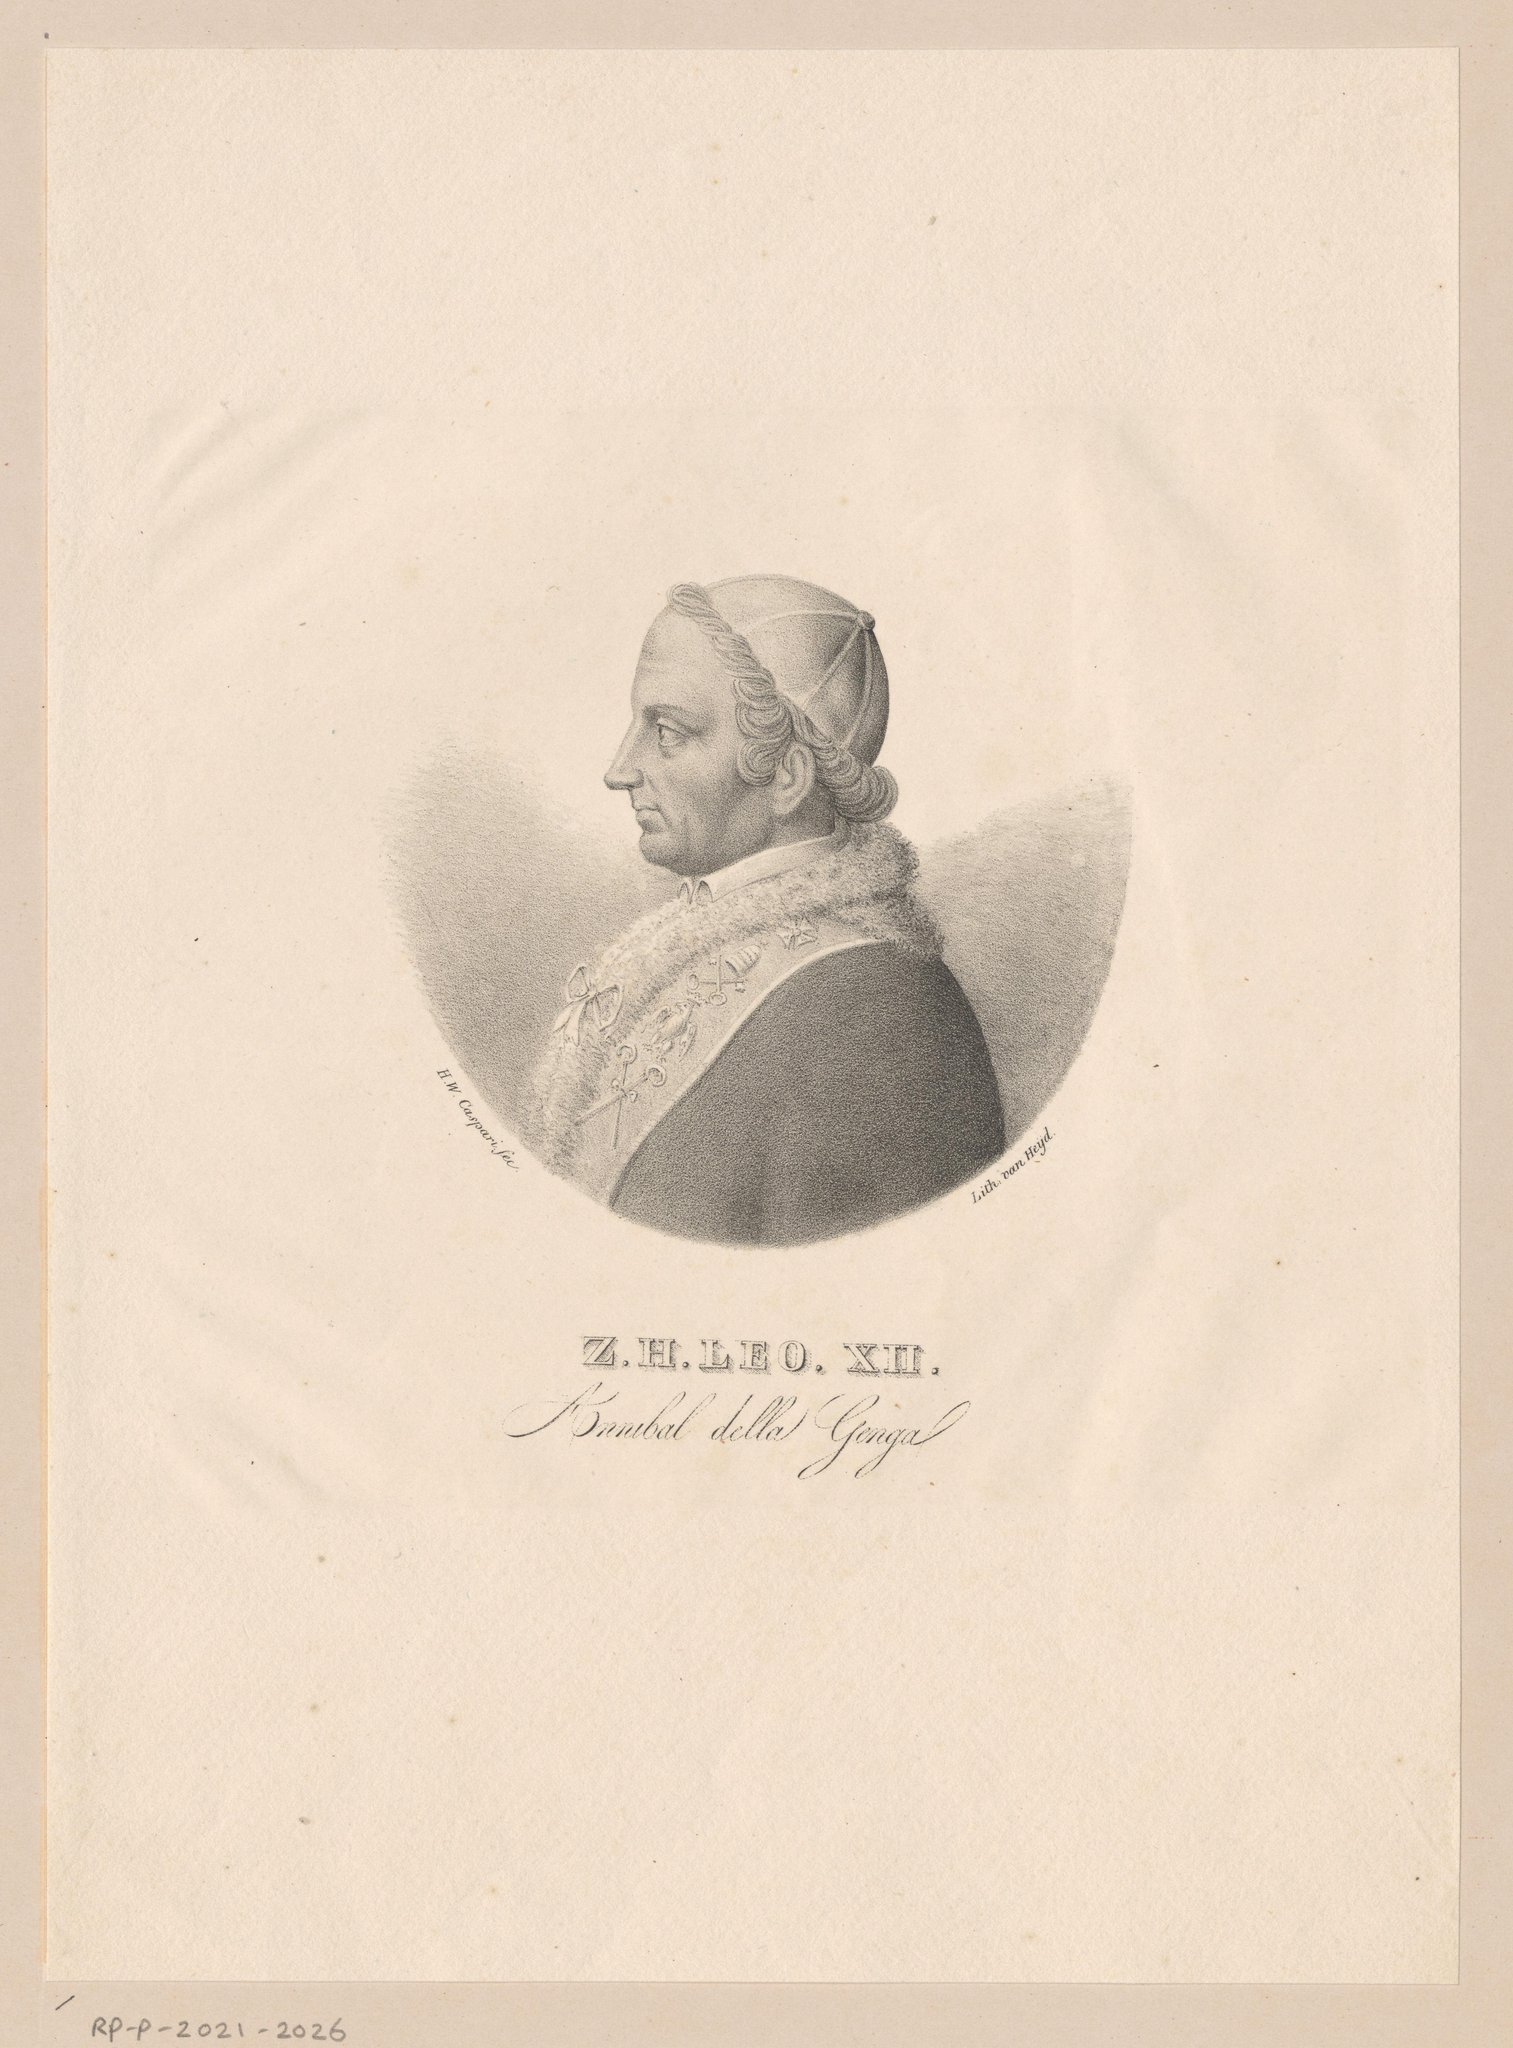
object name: print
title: Portret van paus Leo XII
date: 1823-1829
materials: paper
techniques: lithograph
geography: amsterdam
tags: historical persons, pope